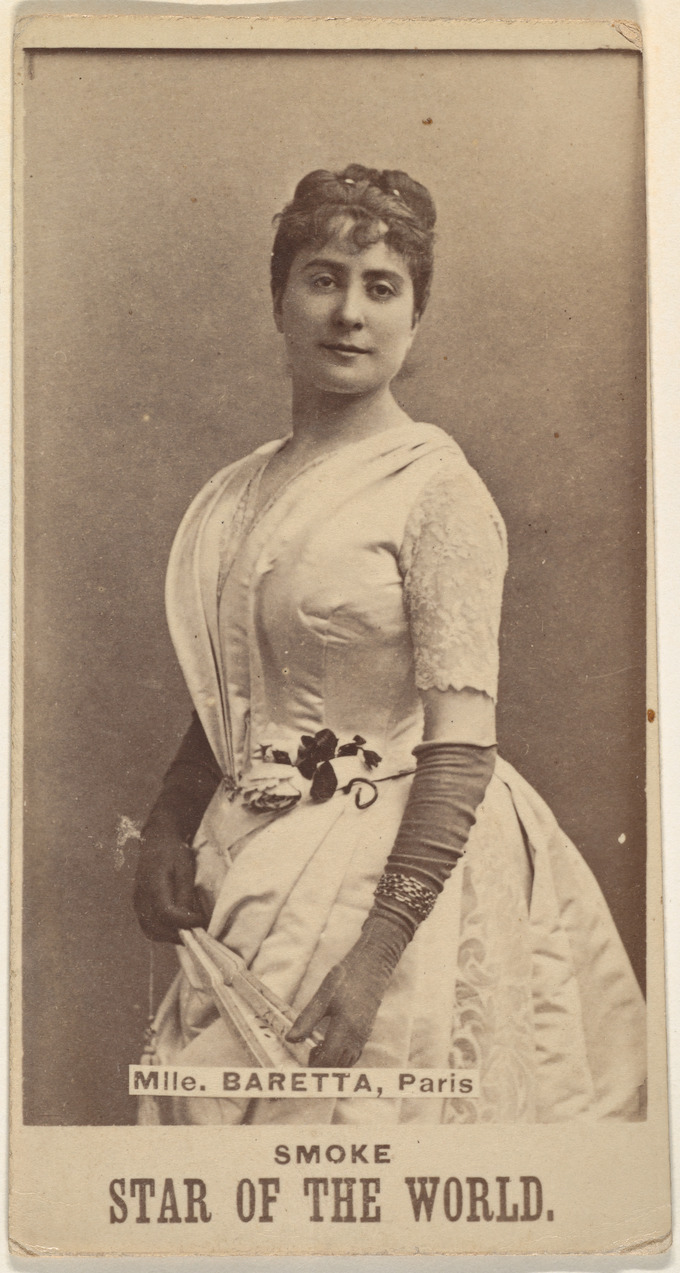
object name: photograph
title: Mlle. Baretta, Paris, from the Star of the World series (N672), issued by A. Hershey & Bros. to promote Star of the World Tobacco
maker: a. hershey & bros.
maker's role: publisher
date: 1888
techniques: albumen silver print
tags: portraits,women,actresses